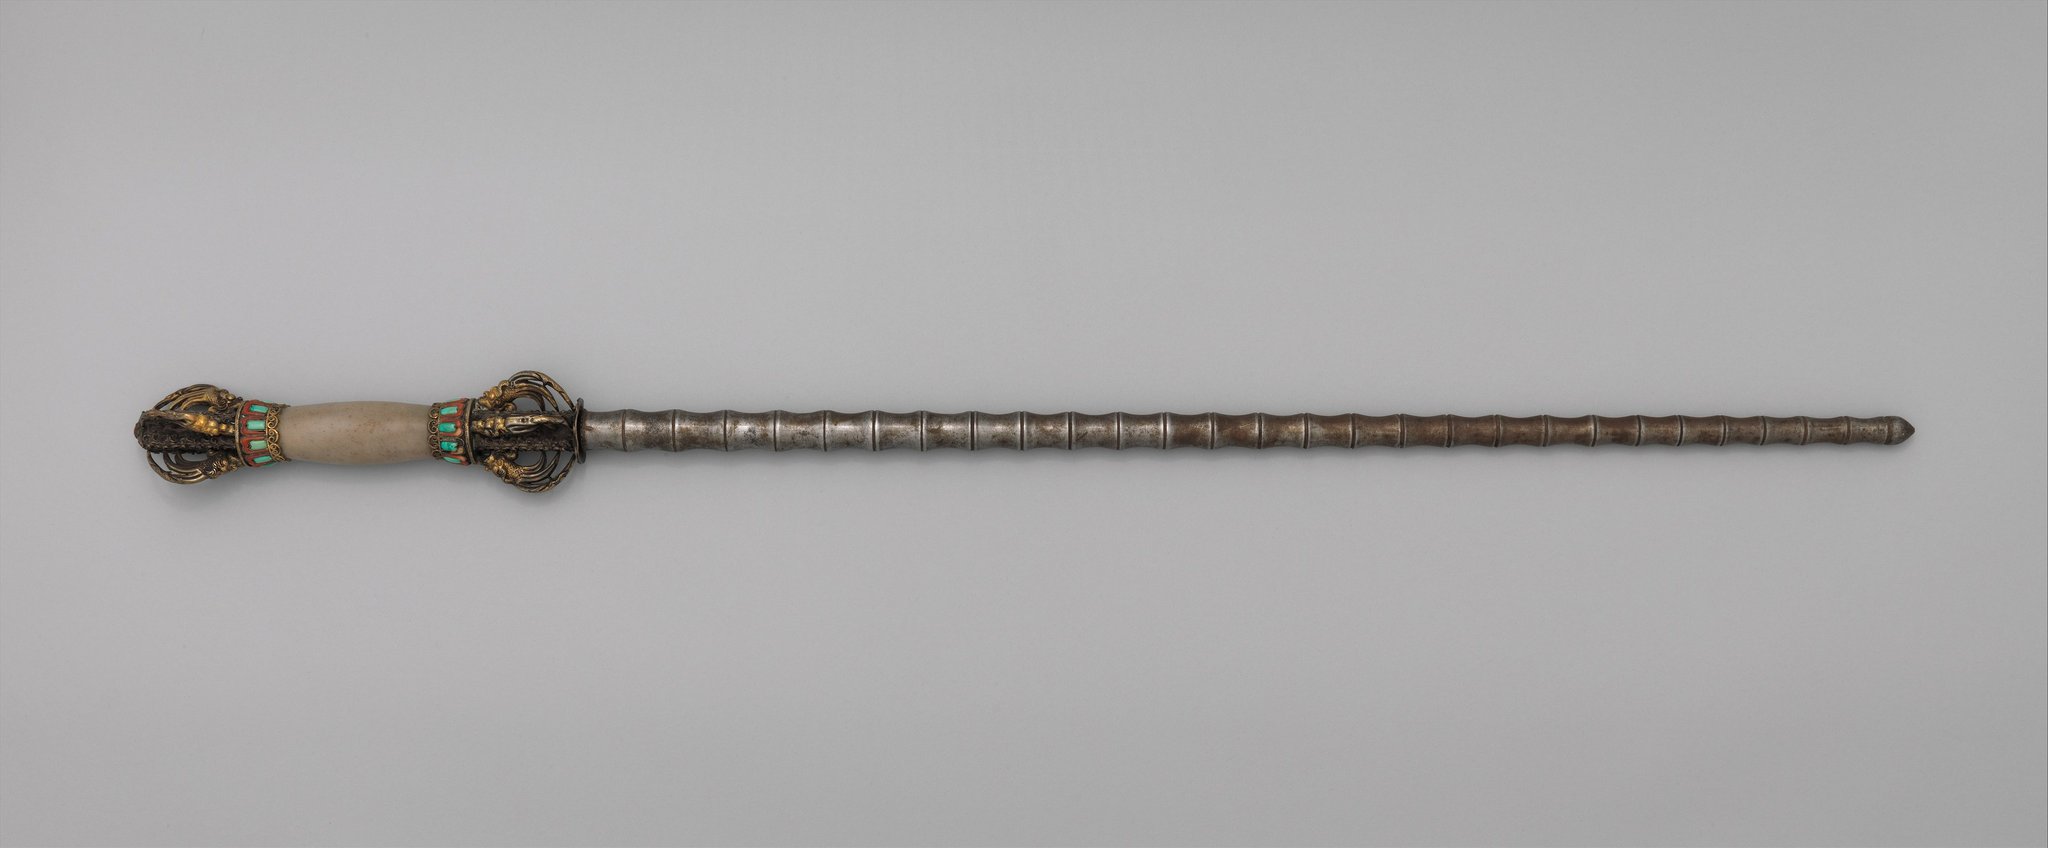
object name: baton bian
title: Baton (Bian)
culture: chinese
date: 1701-1900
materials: stone, coral, gold, iron, silver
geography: china